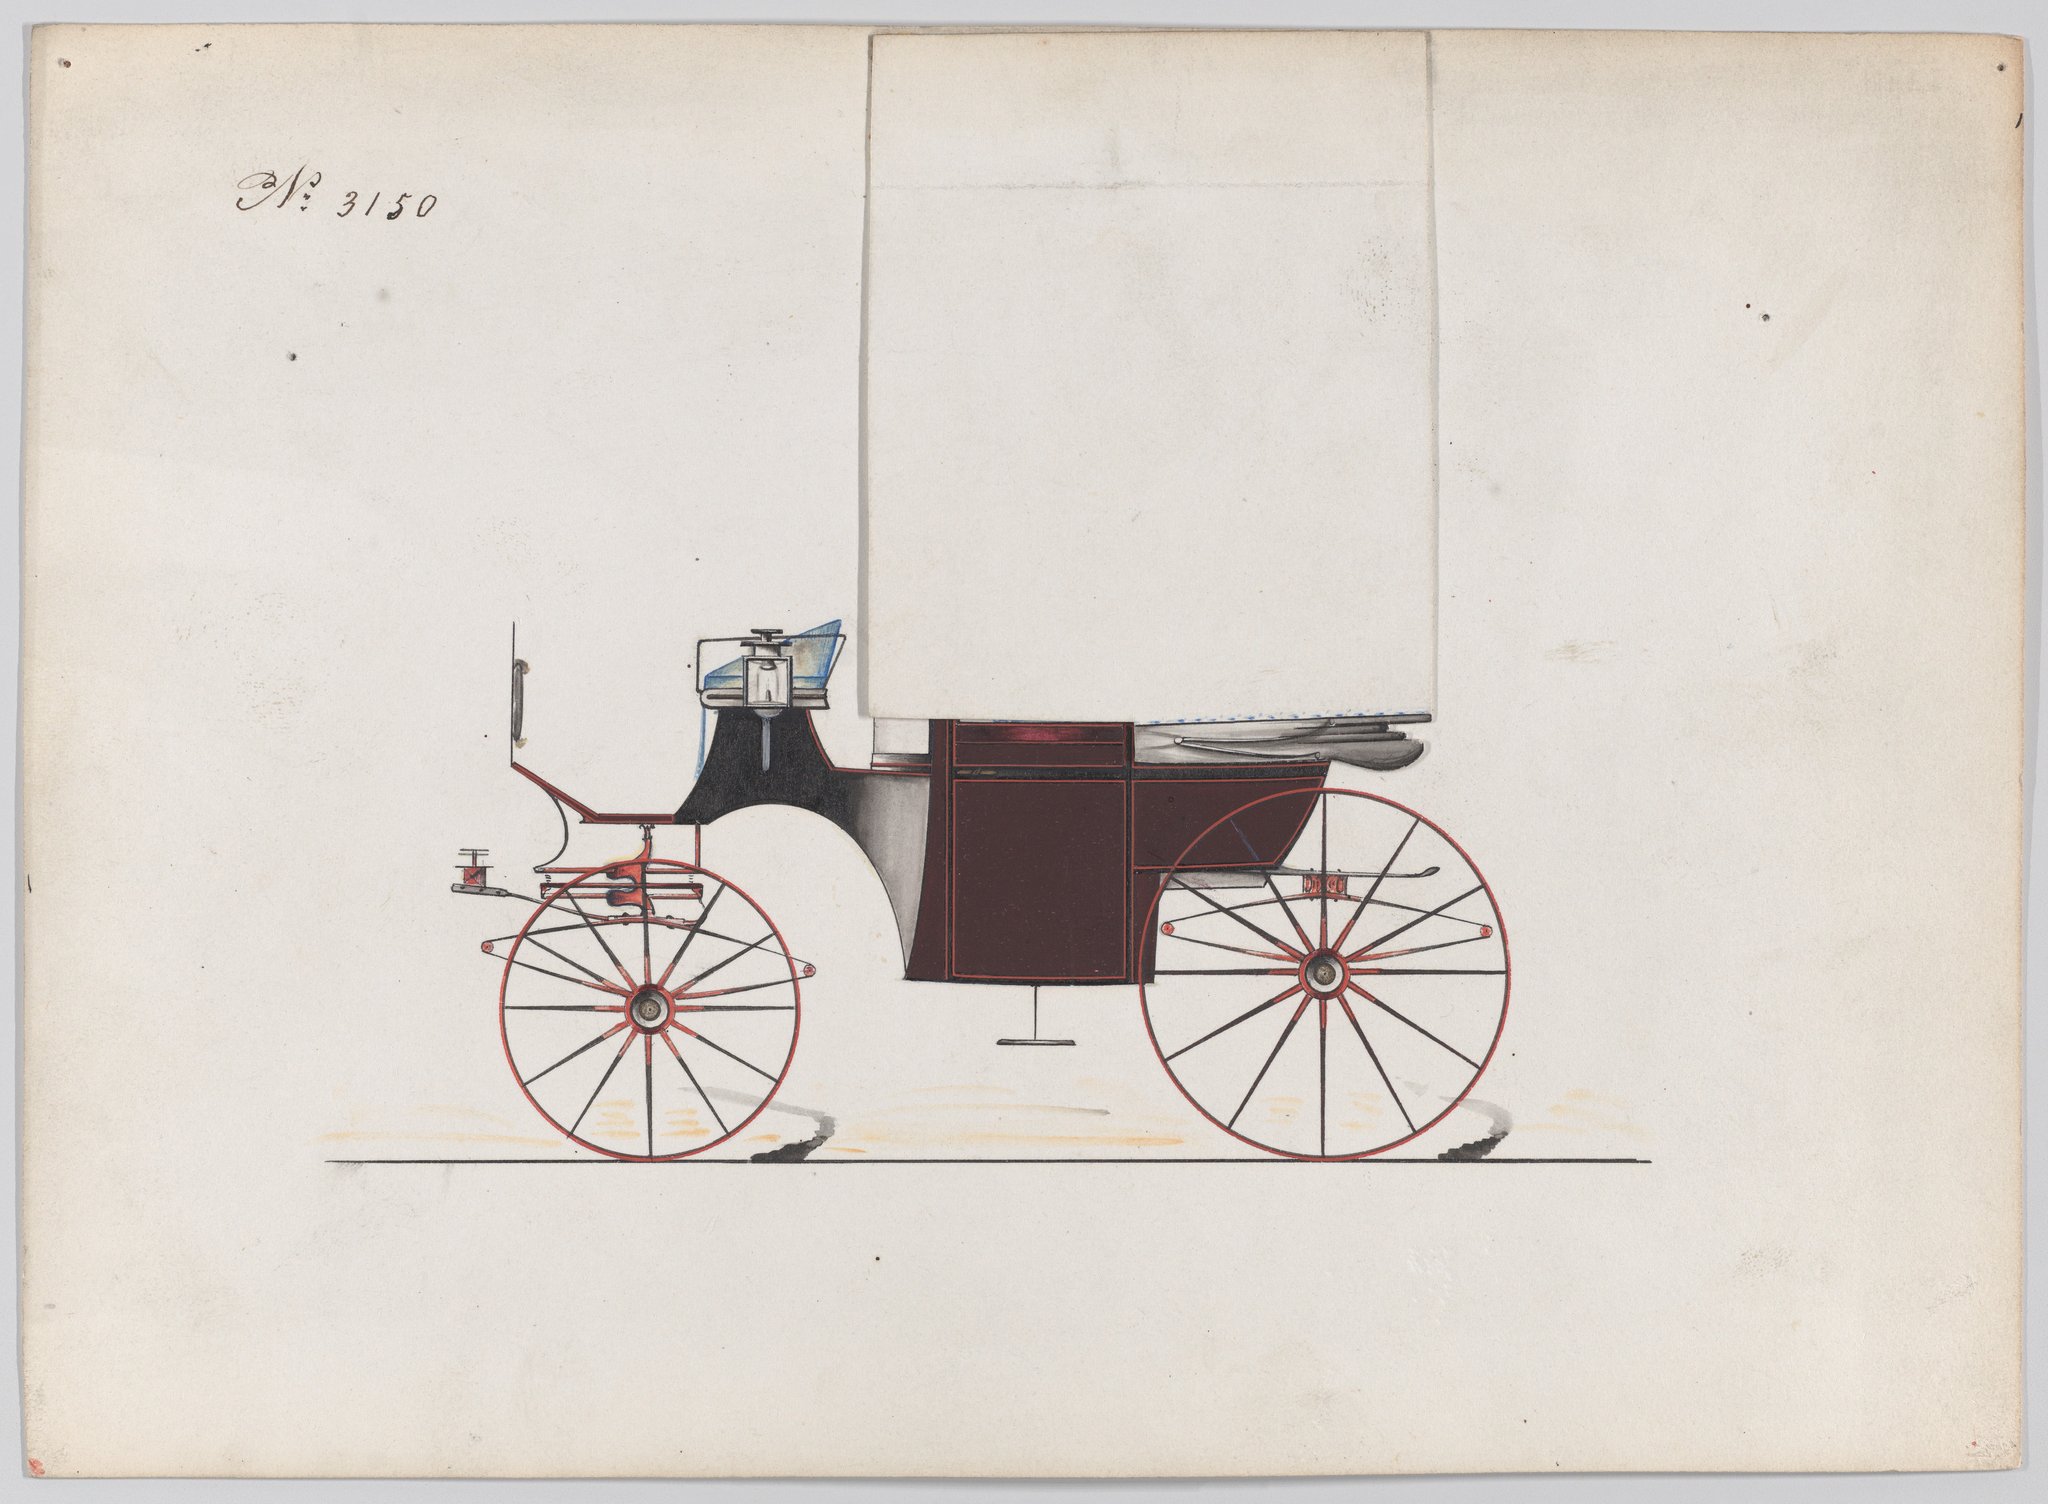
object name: drawing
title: Design for Landaulet, no. 3150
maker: brewster & co.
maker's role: manufacturer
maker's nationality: american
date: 1875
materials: ink, watercolor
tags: carriages